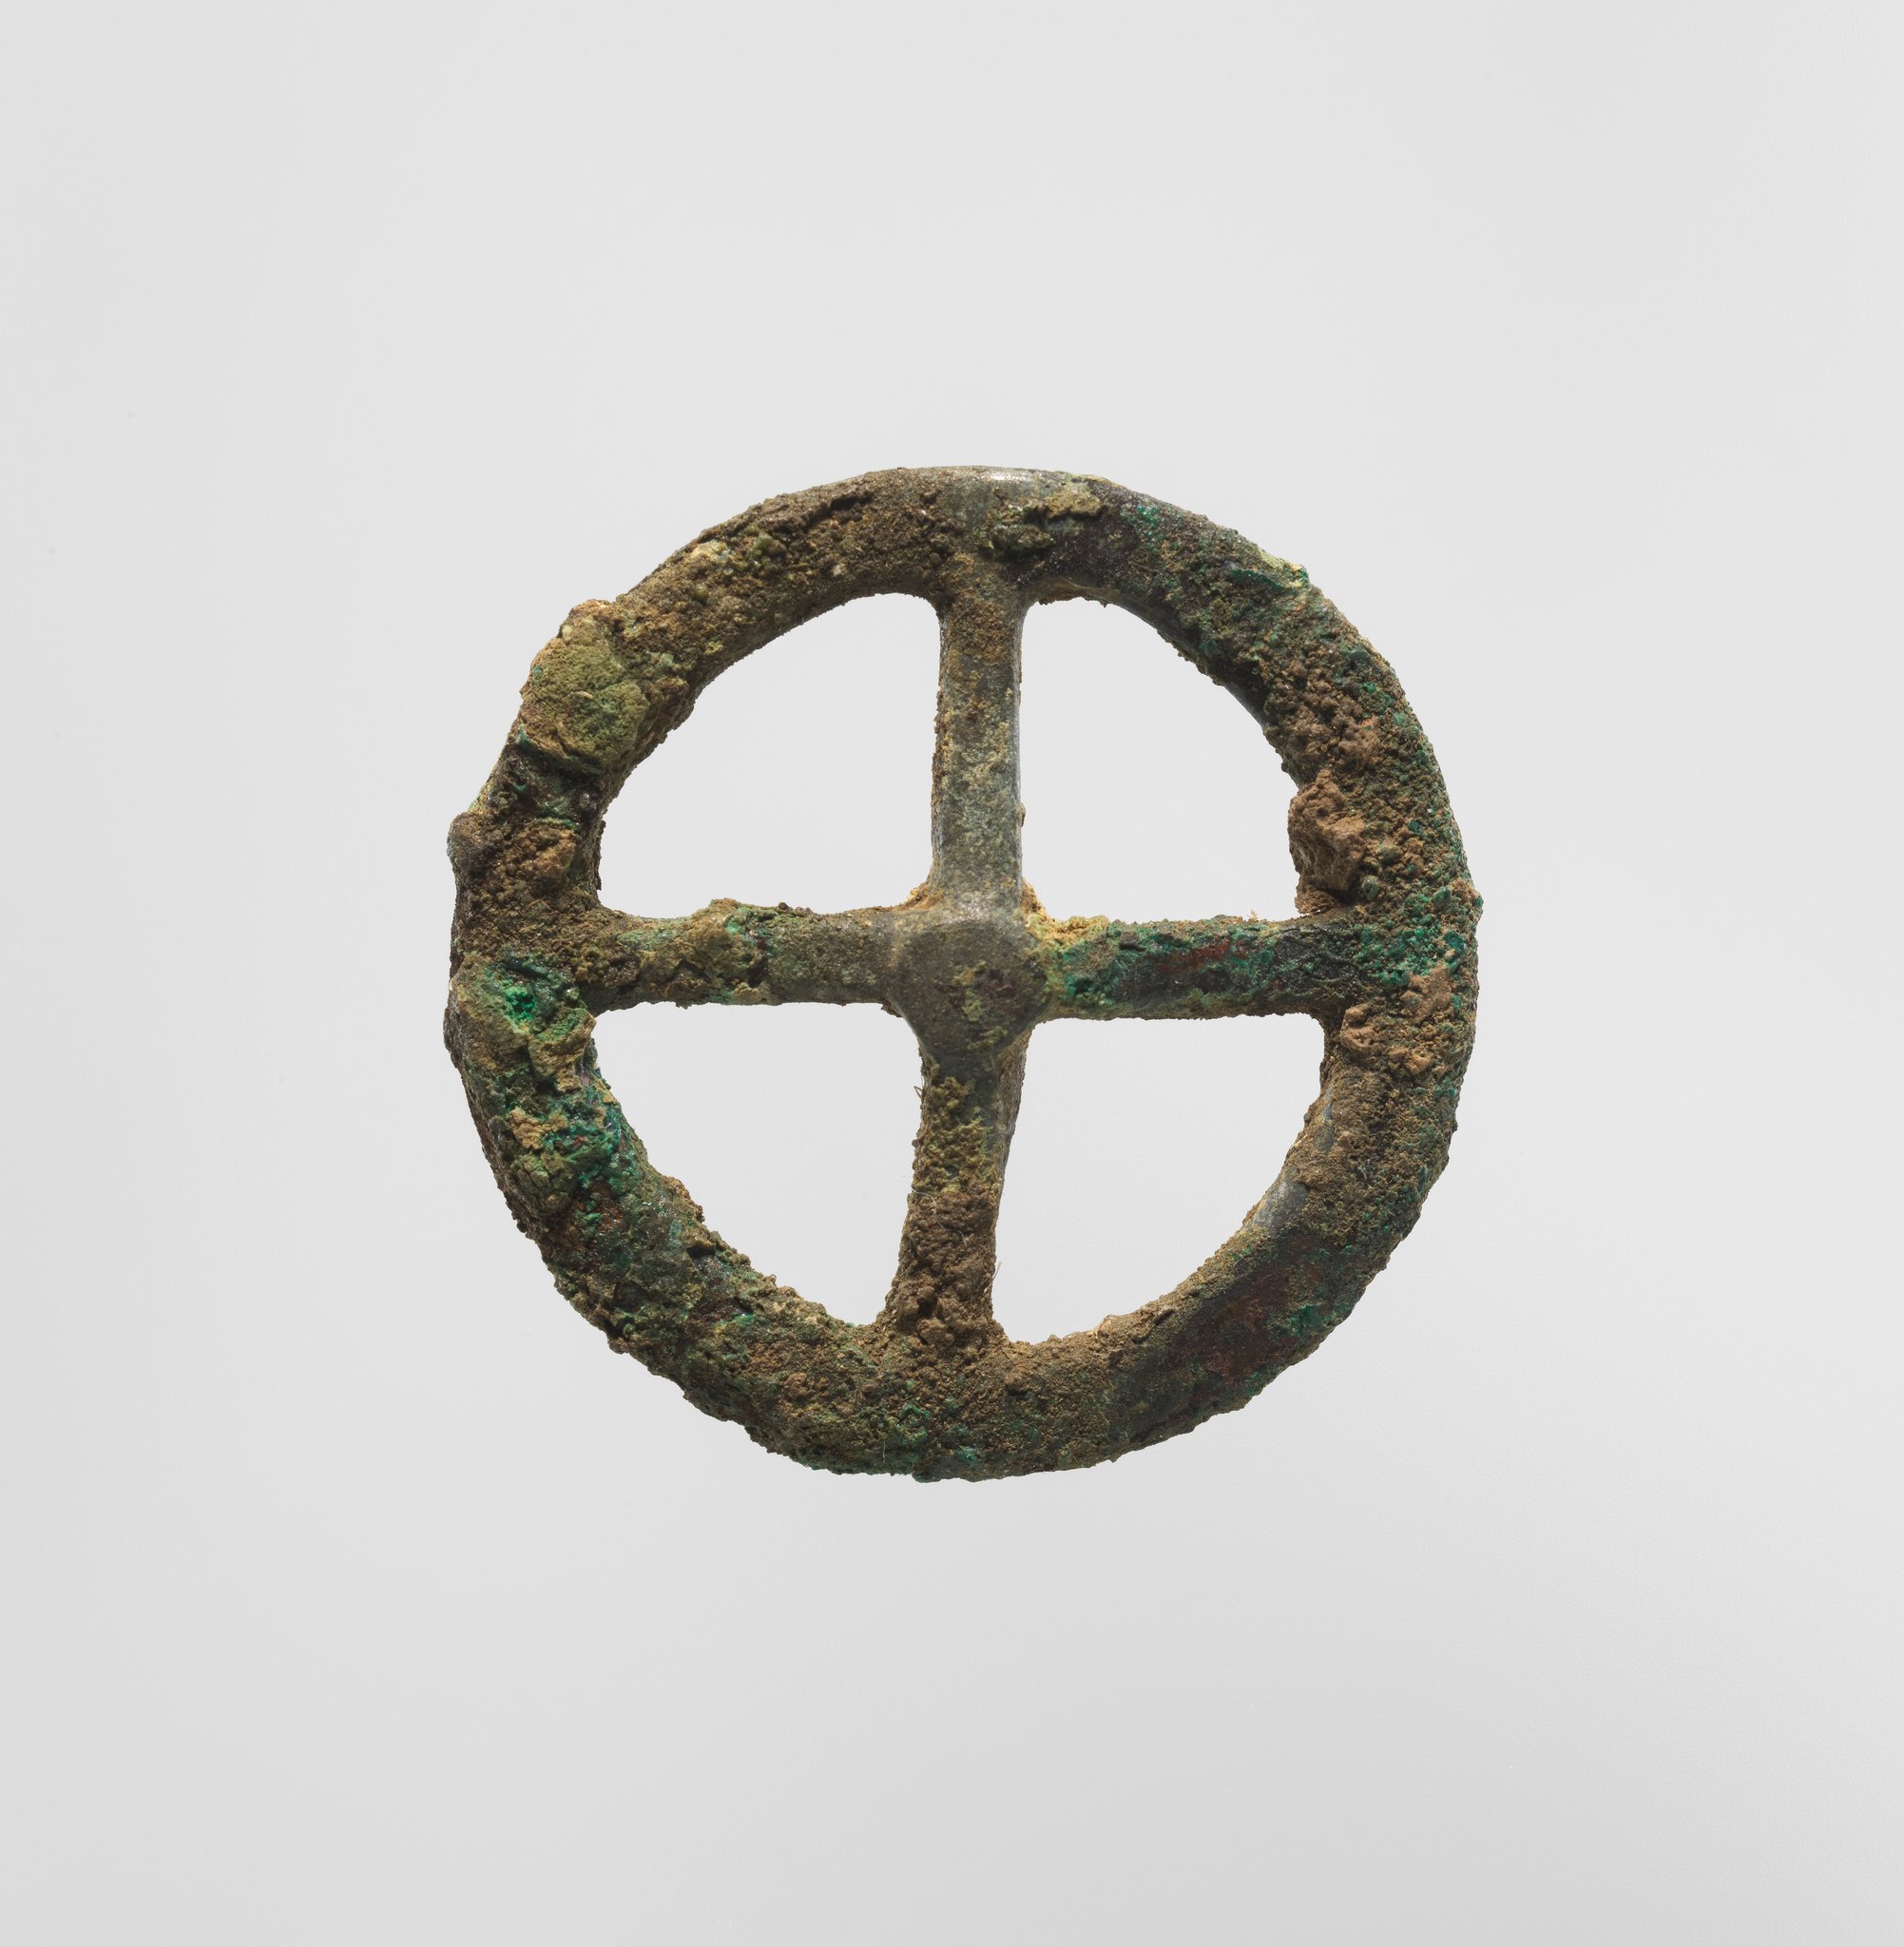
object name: wheel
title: Four-Spoked Votive Wheel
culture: roman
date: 100-300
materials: copper alloy